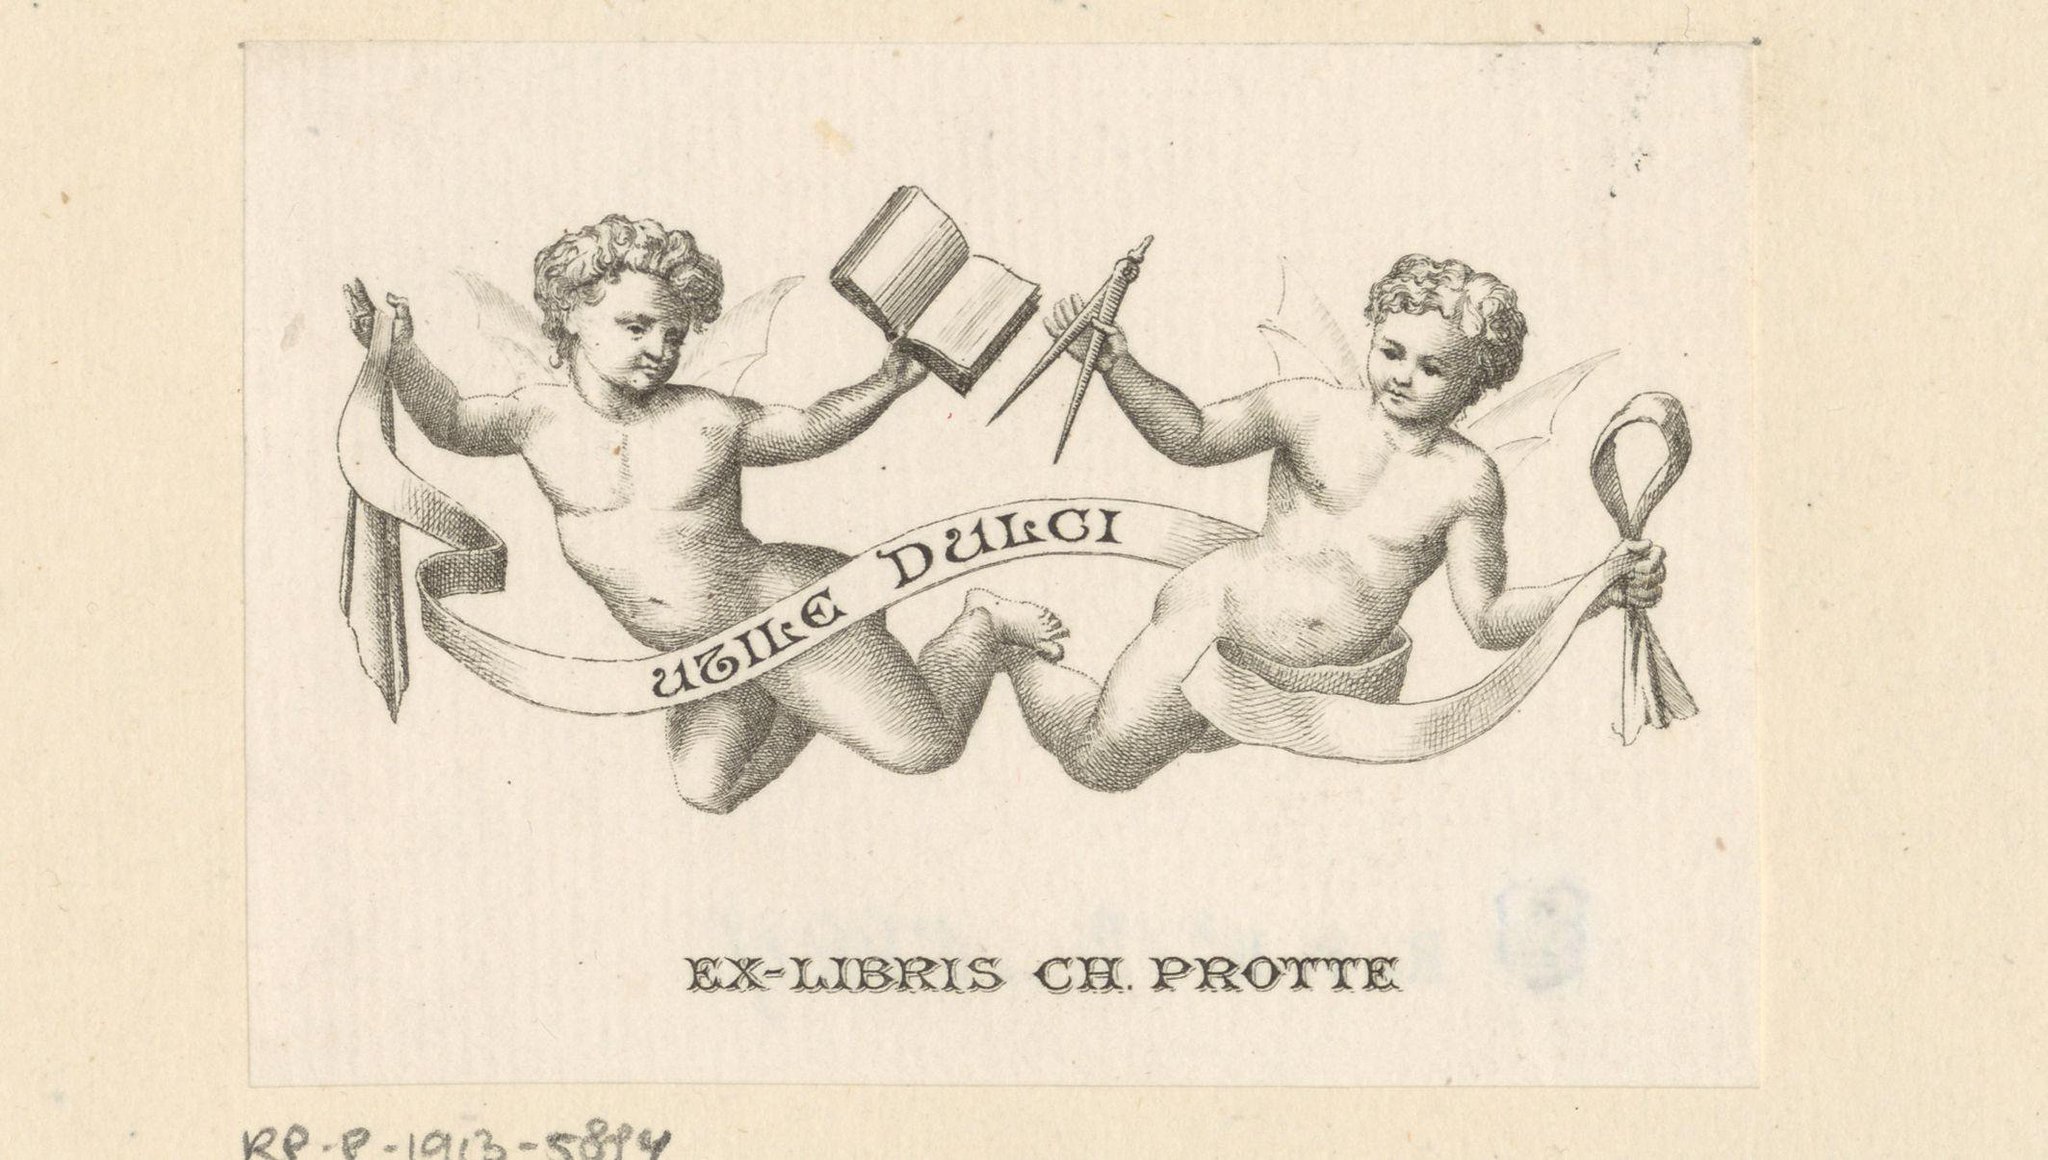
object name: bookplate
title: Utile dulci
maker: Anonymous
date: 1700-1900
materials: paper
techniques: etching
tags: drawing-instruments, book, cupids: 'amores', 'amoretti', 'putti'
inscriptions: collector's mark: Lugt 2760, collector's mark: Lugt 2233